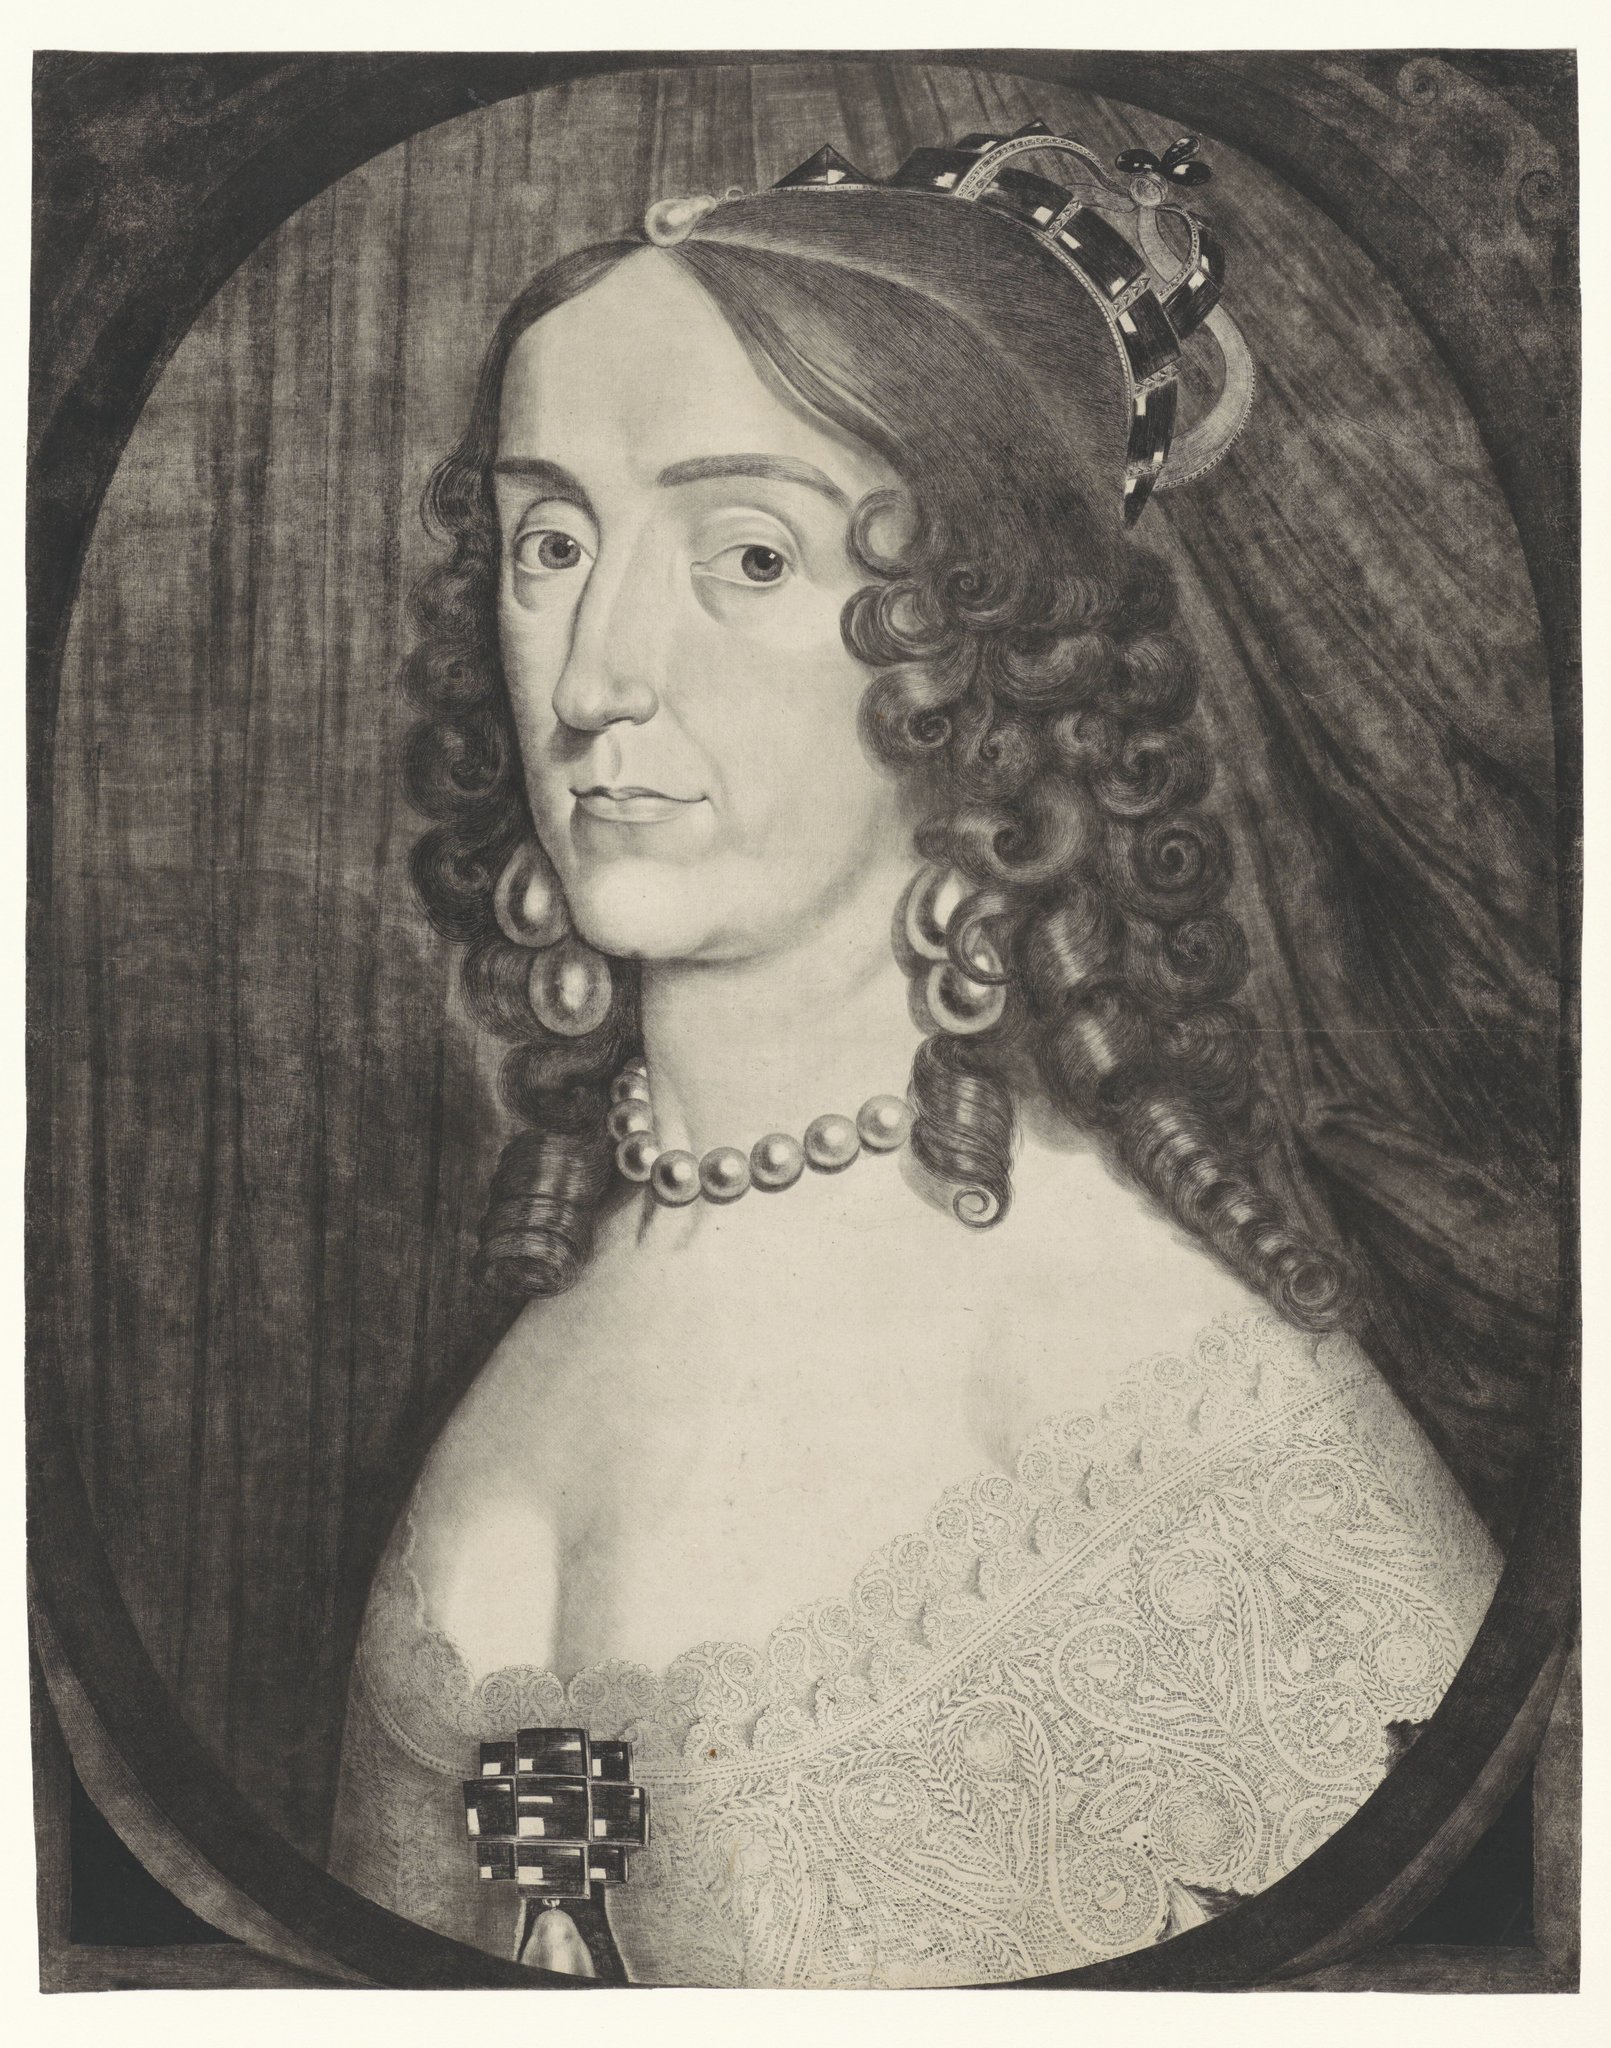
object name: print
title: Portret van Elisabeth Stuart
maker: ludwig von siegen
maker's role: print maker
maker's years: 1609-1680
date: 1643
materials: paper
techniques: etching, roulette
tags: london, crown (symbol of sovereignty), pearl; pearl necklace (+ women's clothes)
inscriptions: collector's mark: Lugt 2228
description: Elisabeth Stuart, keurvorstin van de Palts, koningin van Bohemen. Op het hoofd een kroon en om de hals een parelsnoer.